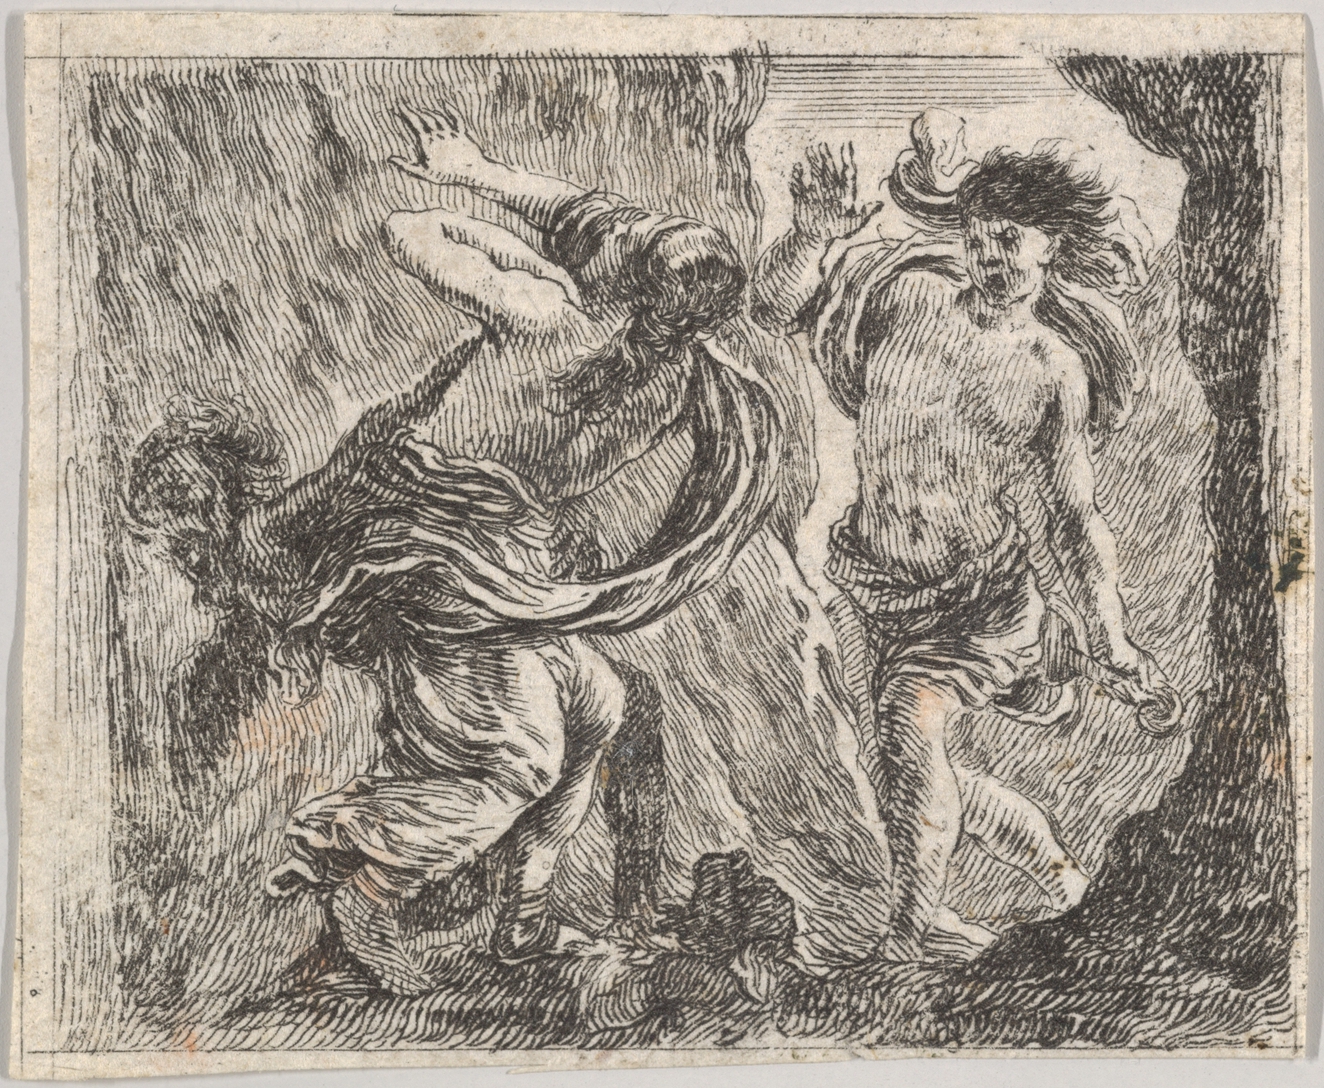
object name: print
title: Orpheus and Eurydice, from "Game of Mythology" (Jeu de la Mythologie)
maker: stefano della bella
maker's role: artist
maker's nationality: italian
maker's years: 1610-1664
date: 1644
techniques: etching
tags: orpheus,eurydice